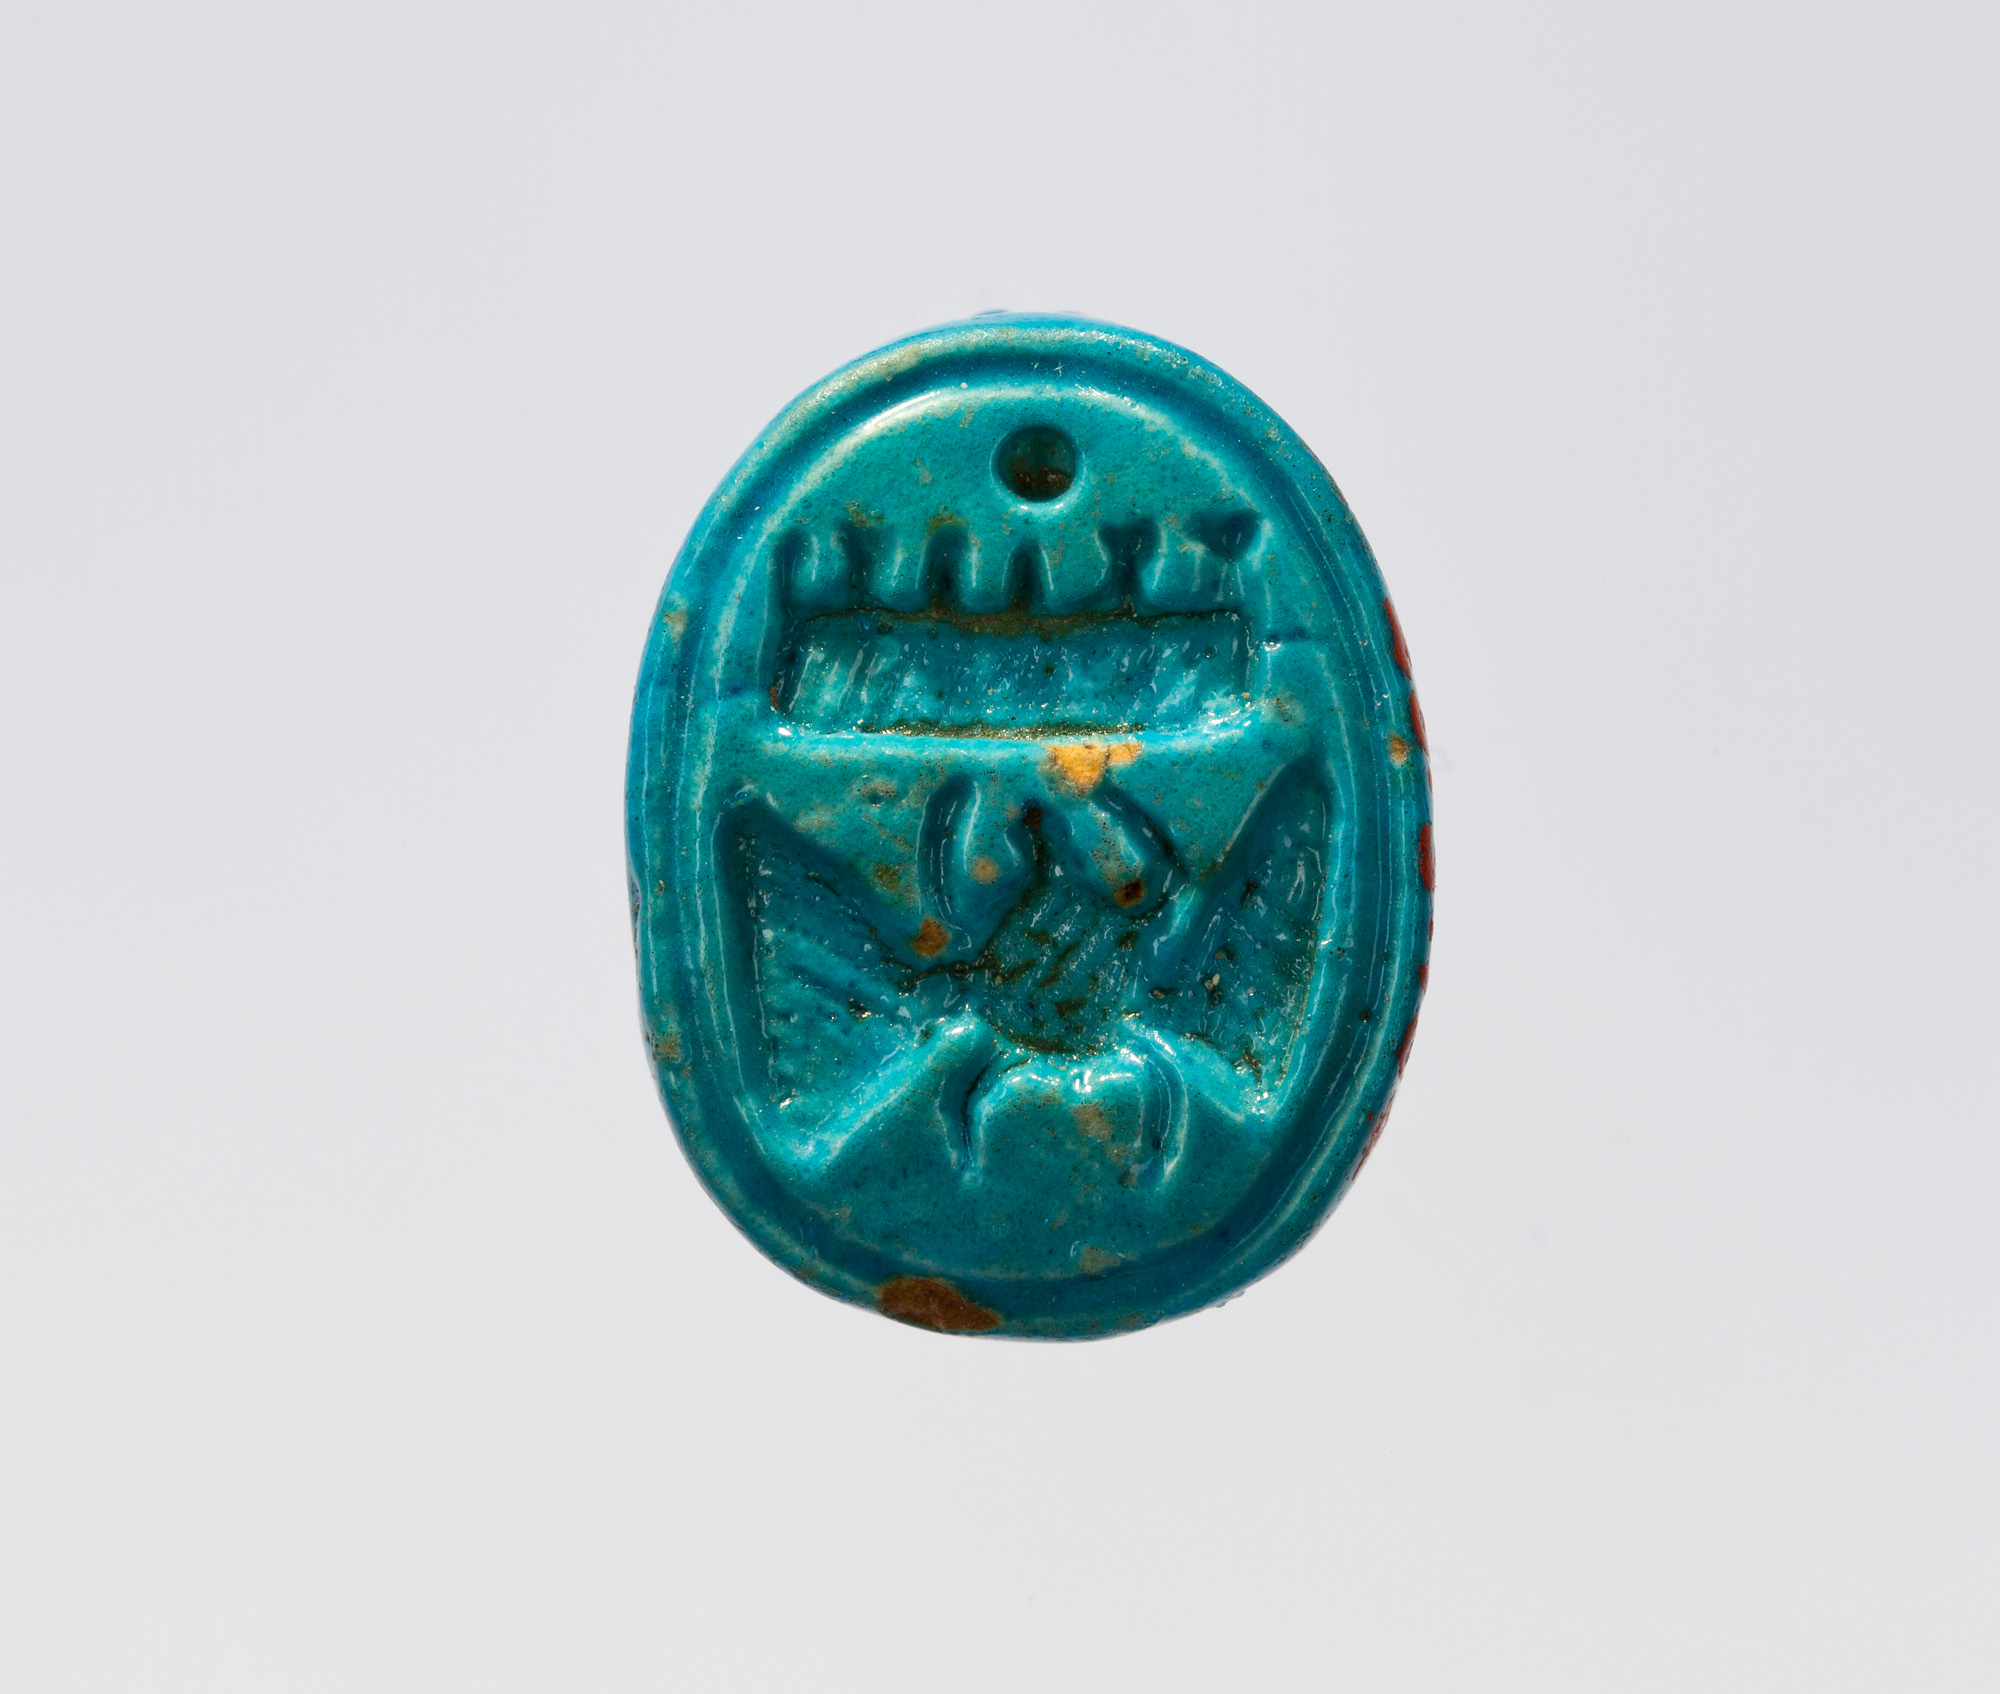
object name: scarab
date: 1479-1458 BCE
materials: faience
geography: egypt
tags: scarabs